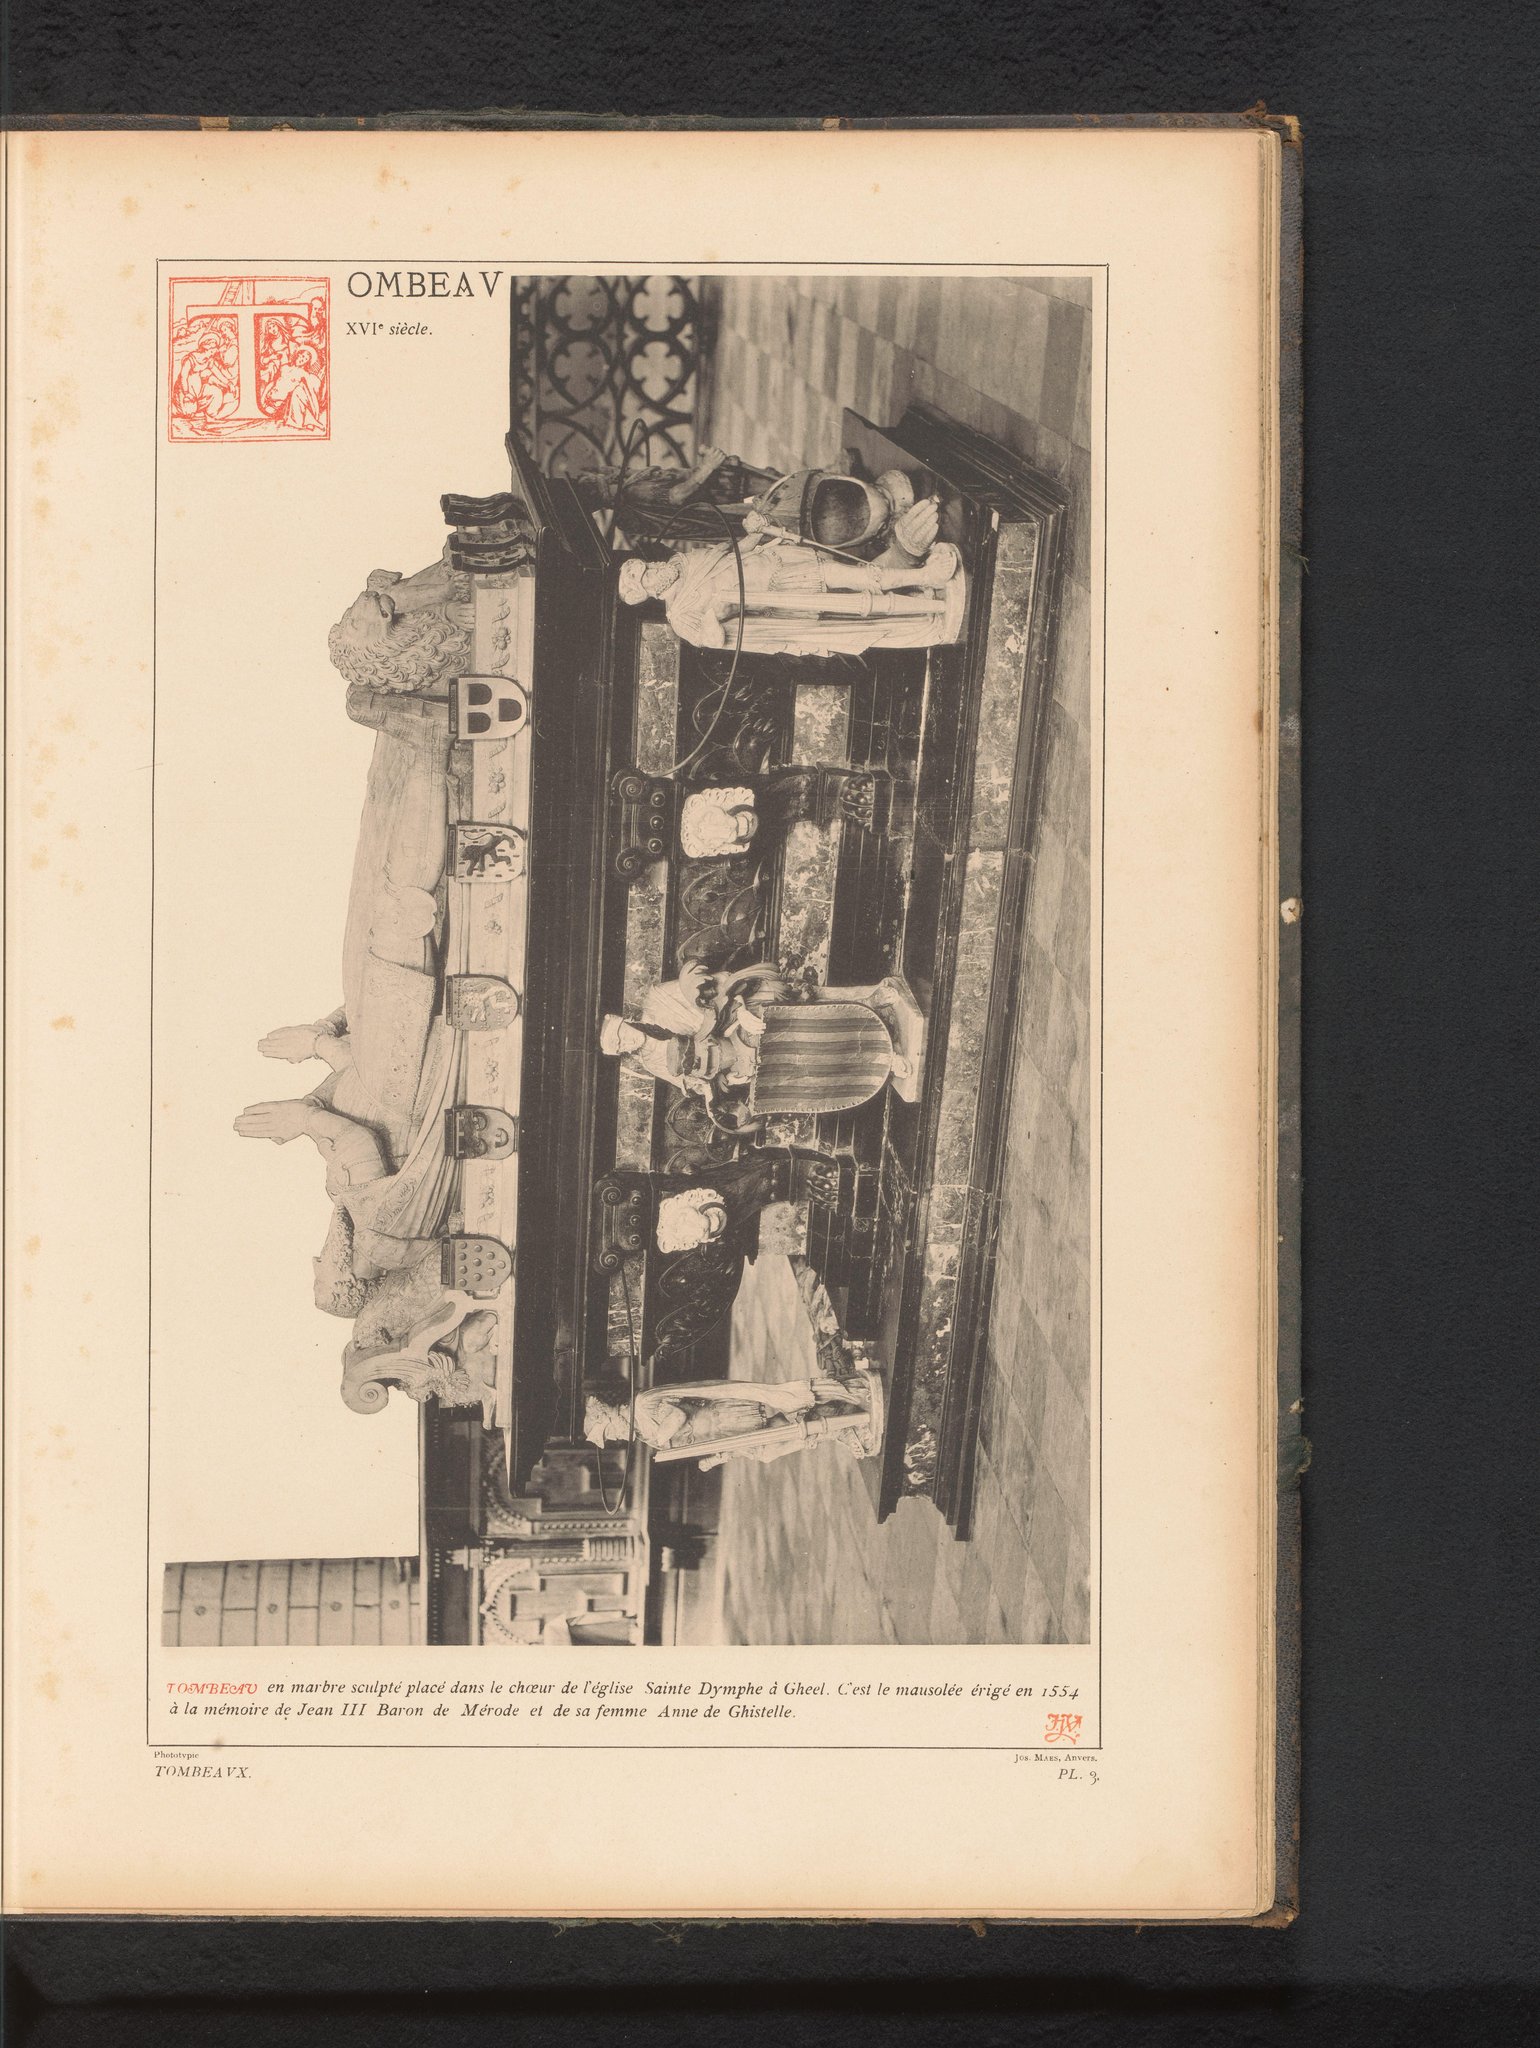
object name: page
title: Graftombe van Jan III van Merode Pietershem in de Sint-Dimpnakerk in Geel, België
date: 1882-1887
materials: paper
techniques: photograph, photolithography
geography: sint-dimpnakerk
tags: gravestone, tombstone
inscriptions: inscription: ‘TOMBEAUX en marbre (...)’, monogram: ‘JJvY’, inscription: ‘TOMBEAUX. - PL. 3.’